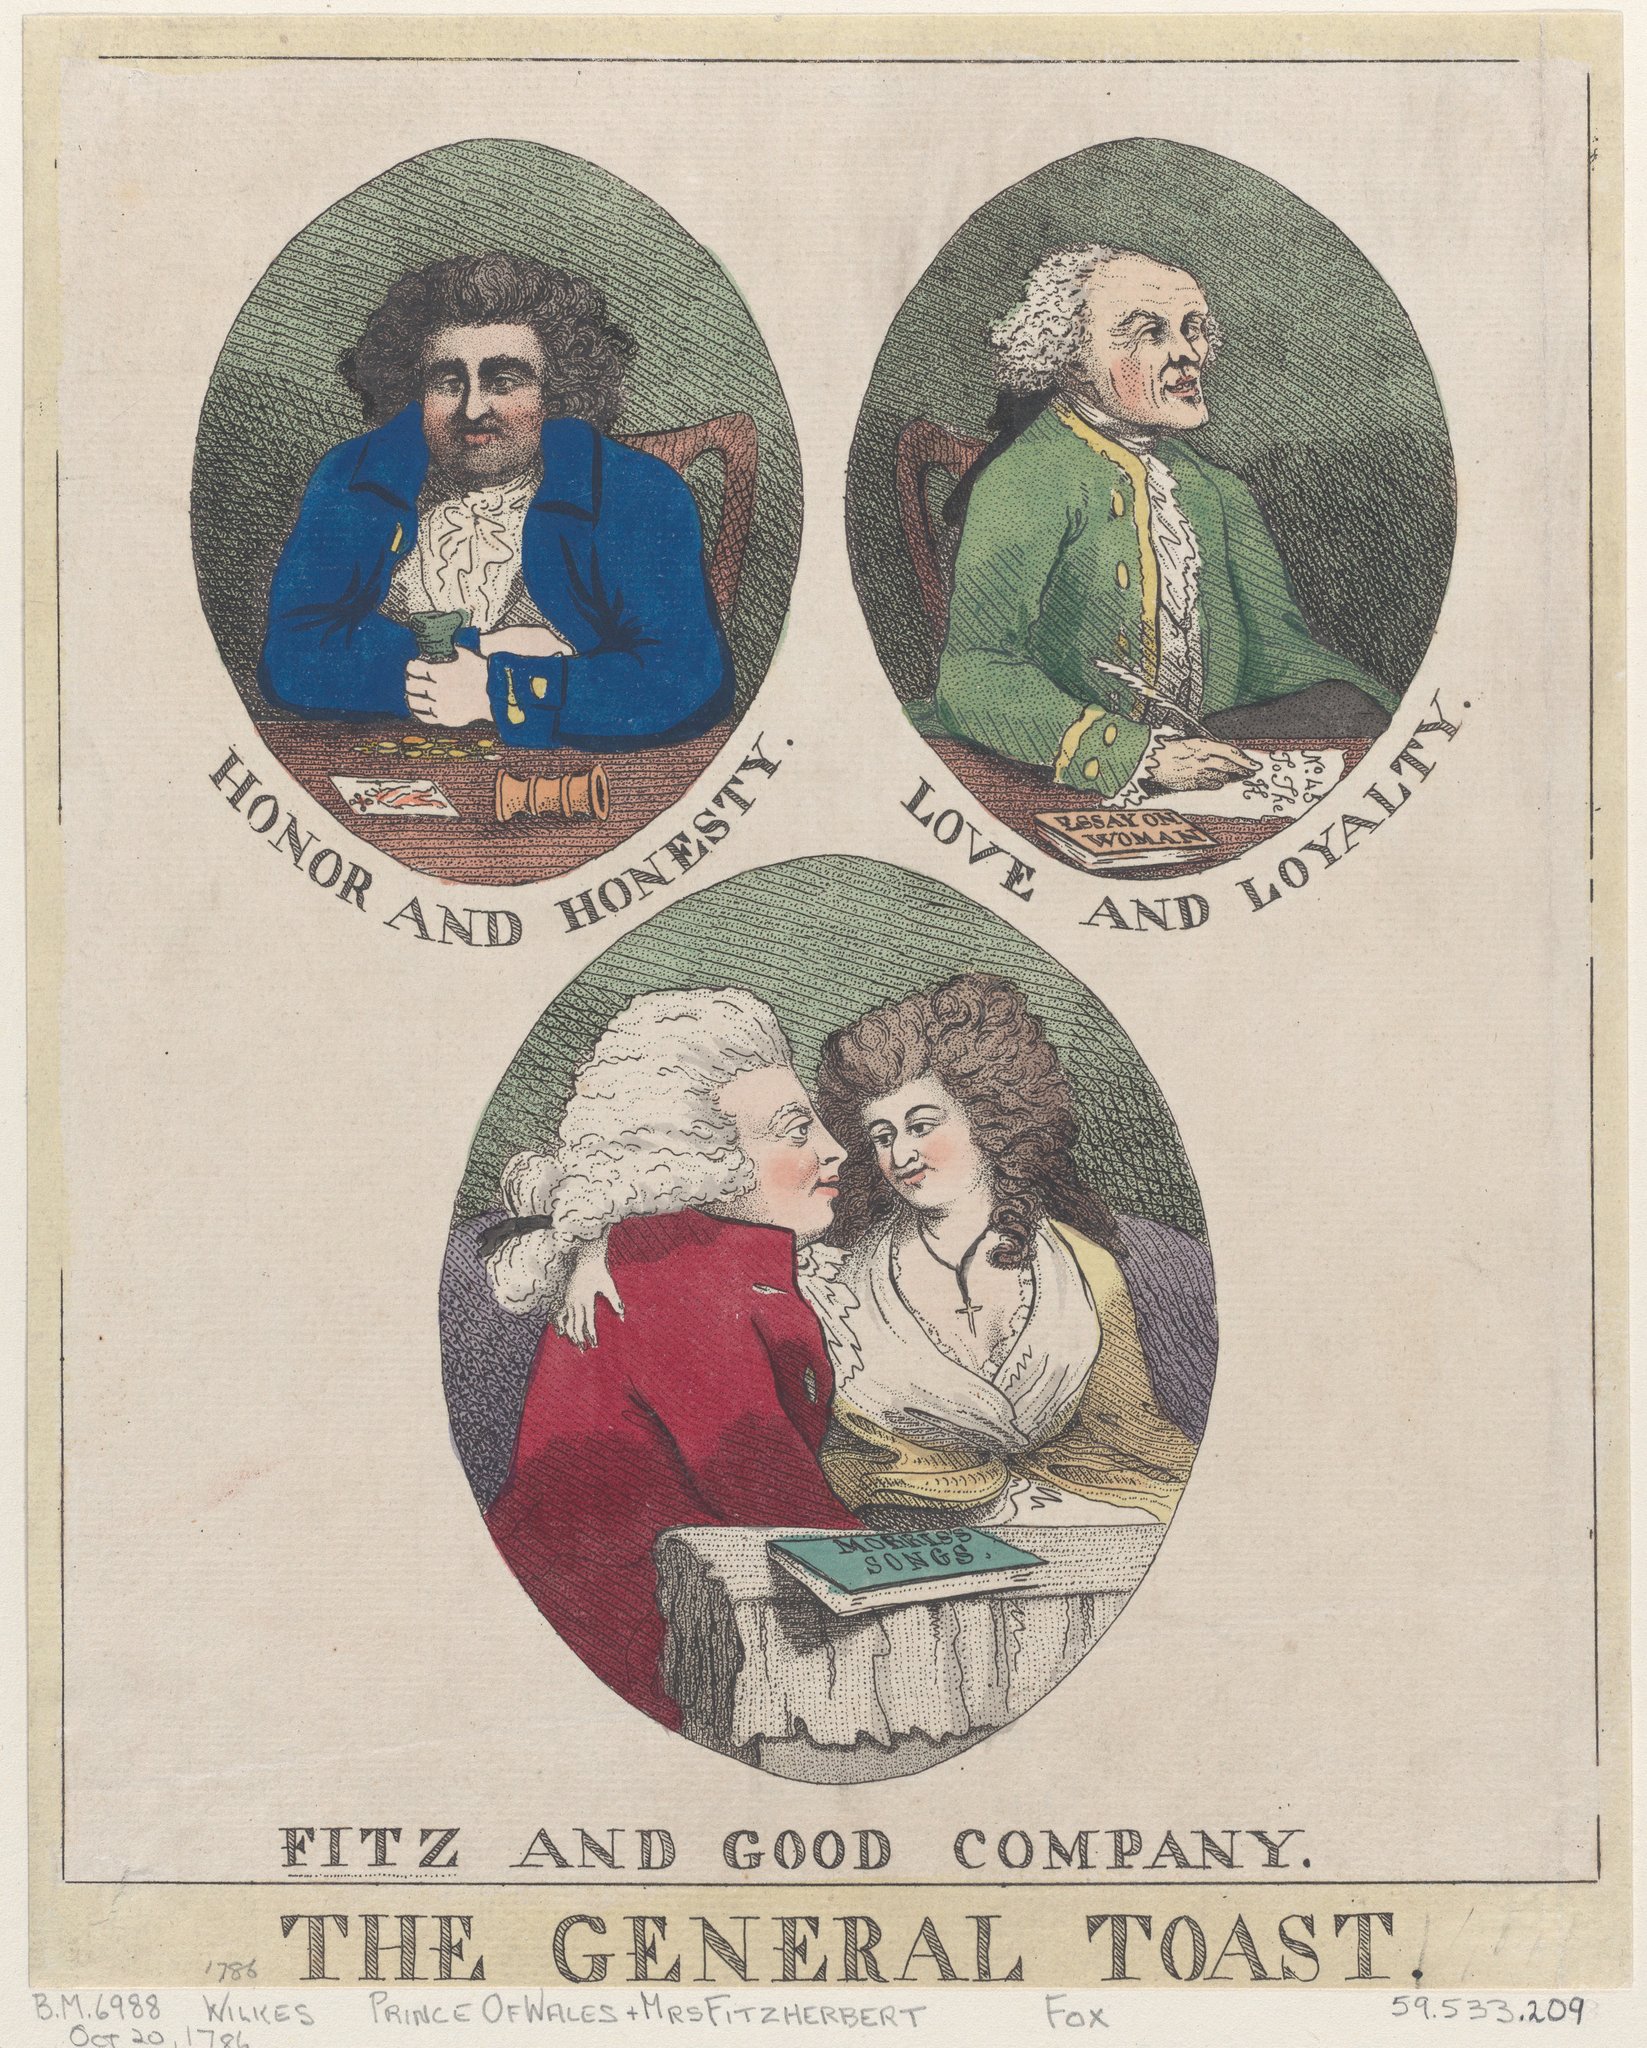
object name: print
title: The General Toast: Honor and Honesty, Love and Loyalty, Fitz and Good Company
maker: anonymous, british, 18th century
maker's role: artist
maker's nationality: british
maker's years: 1700-1800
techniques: etching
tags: satire,men,women